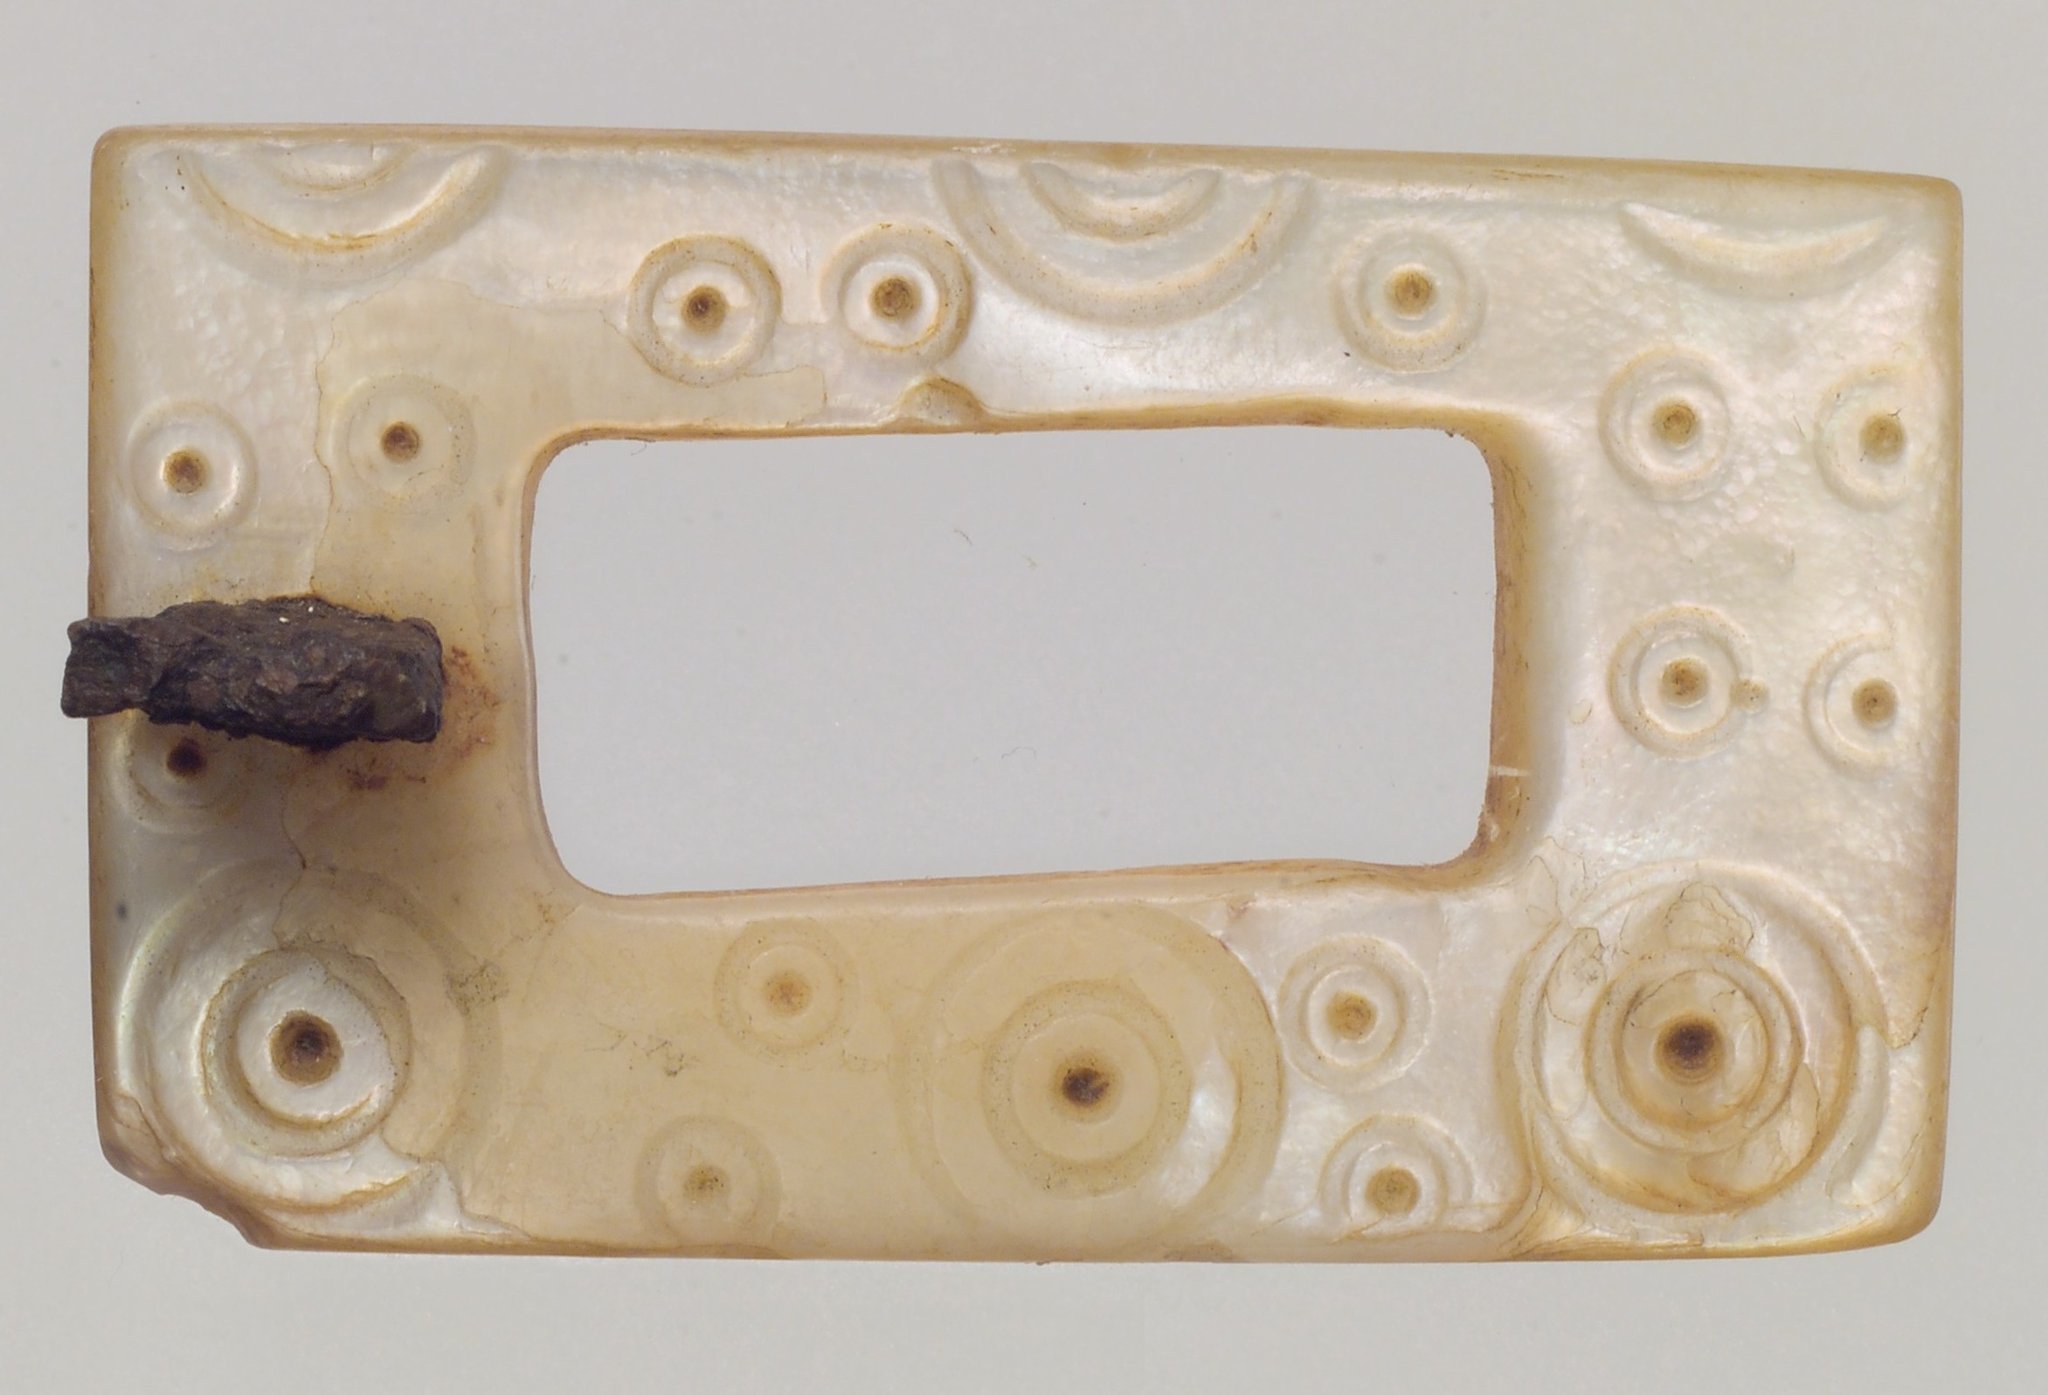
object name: buckle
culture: parthian or sasanian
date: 101-400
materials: iron, shell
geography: iran